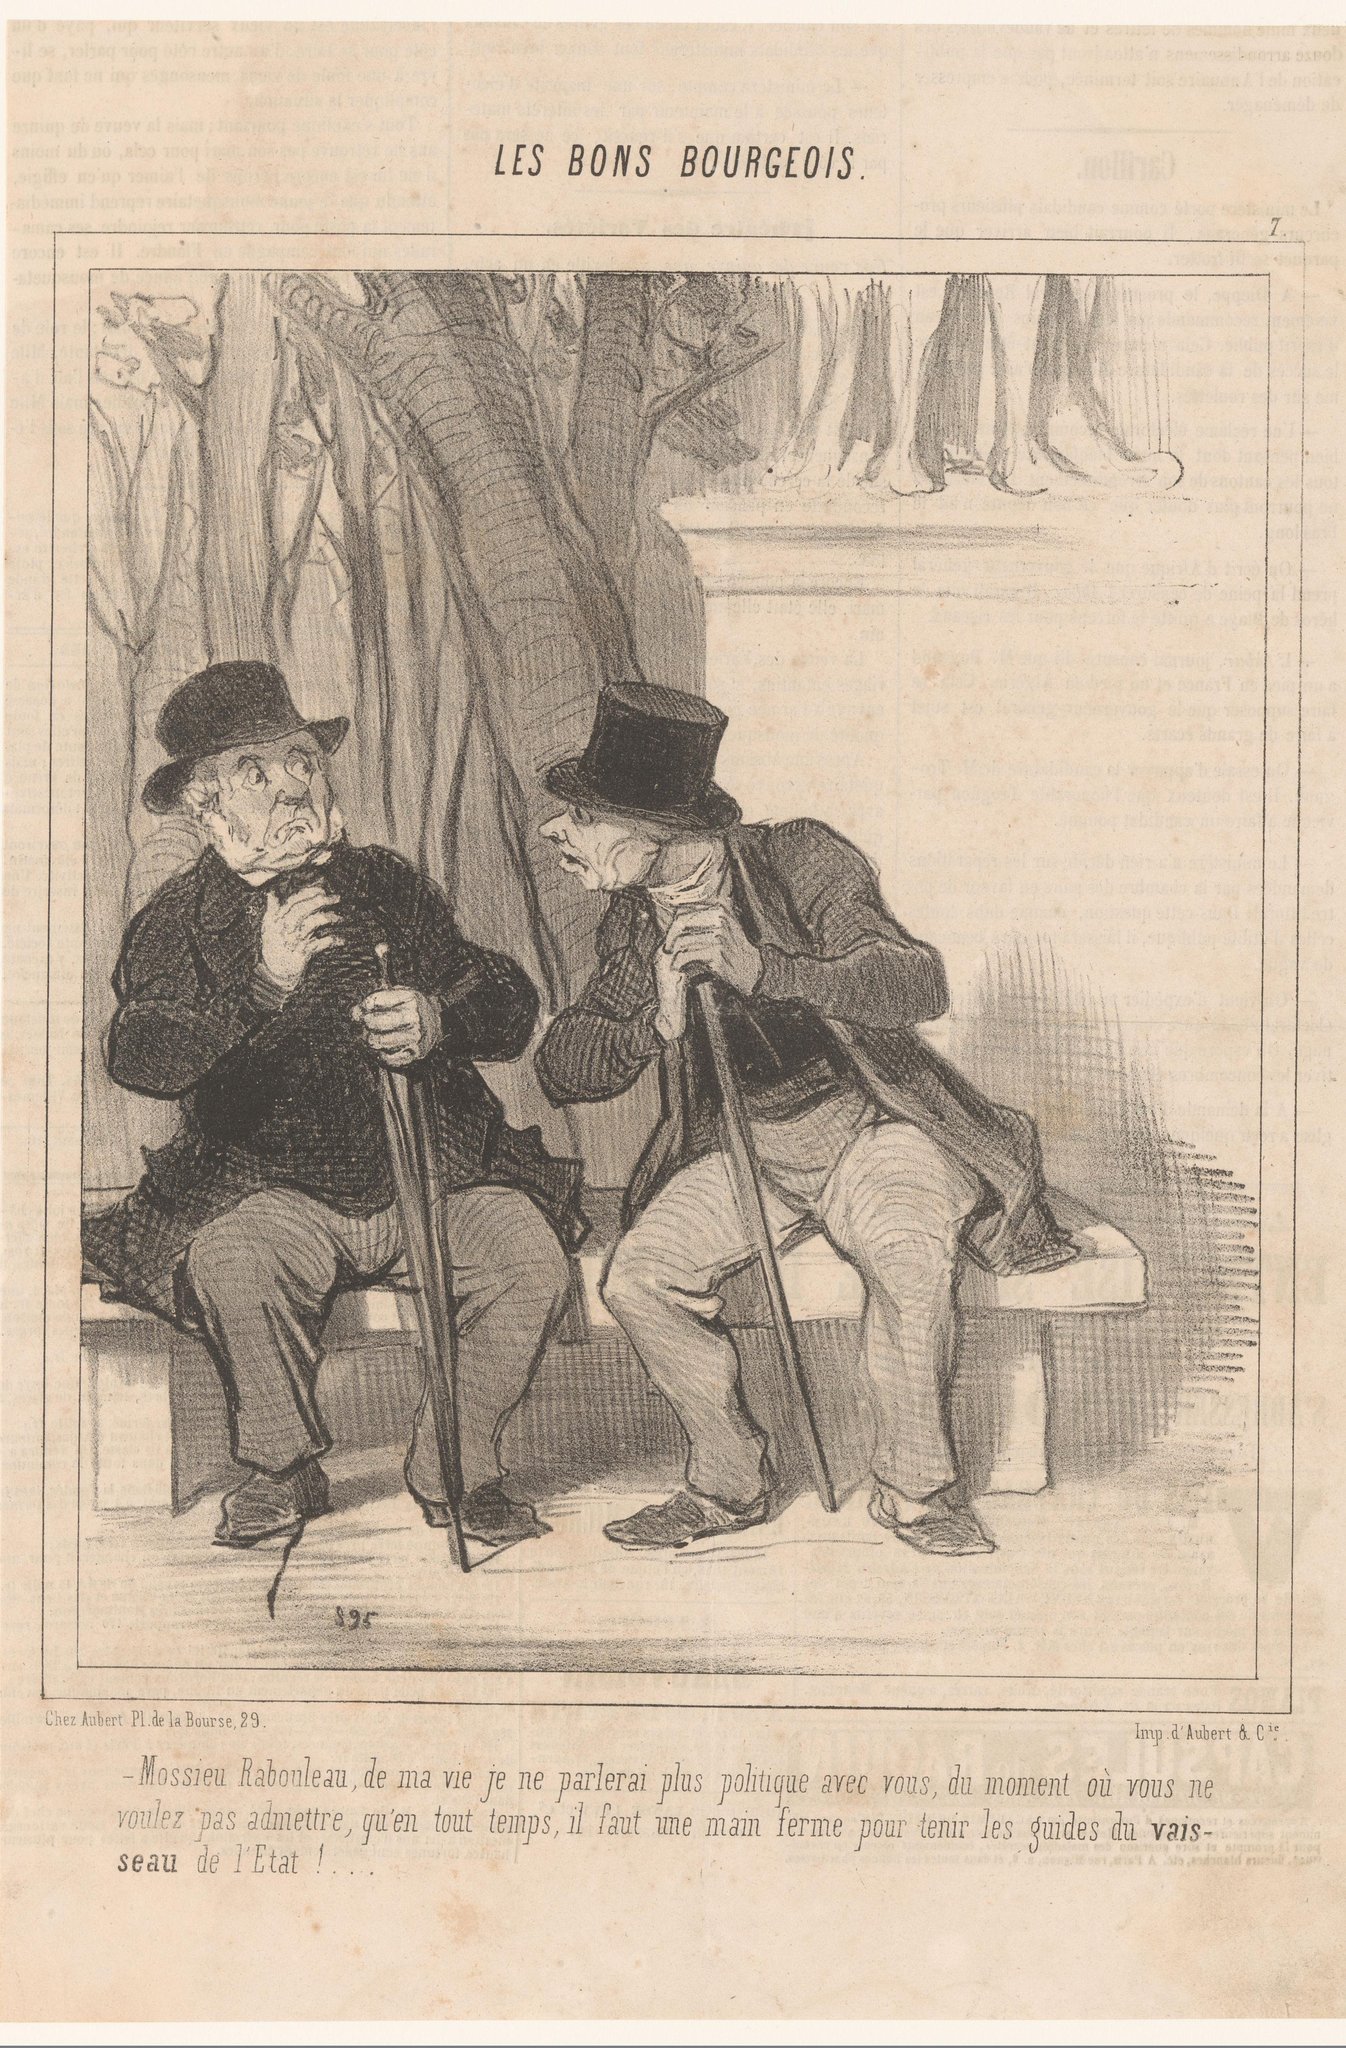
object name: cartoon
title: Goede burgers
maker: honoré daumier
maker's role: draughtsman, painter, print maker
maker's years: 1808-1879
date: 1846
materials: paper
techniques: lithograph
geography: paris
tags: political theory, political ideology, caricatures (human types), old man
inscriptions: collector's mark: Lugt 2228a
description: Prent gebruikt voor: Le Charivari, 04-07-1846.